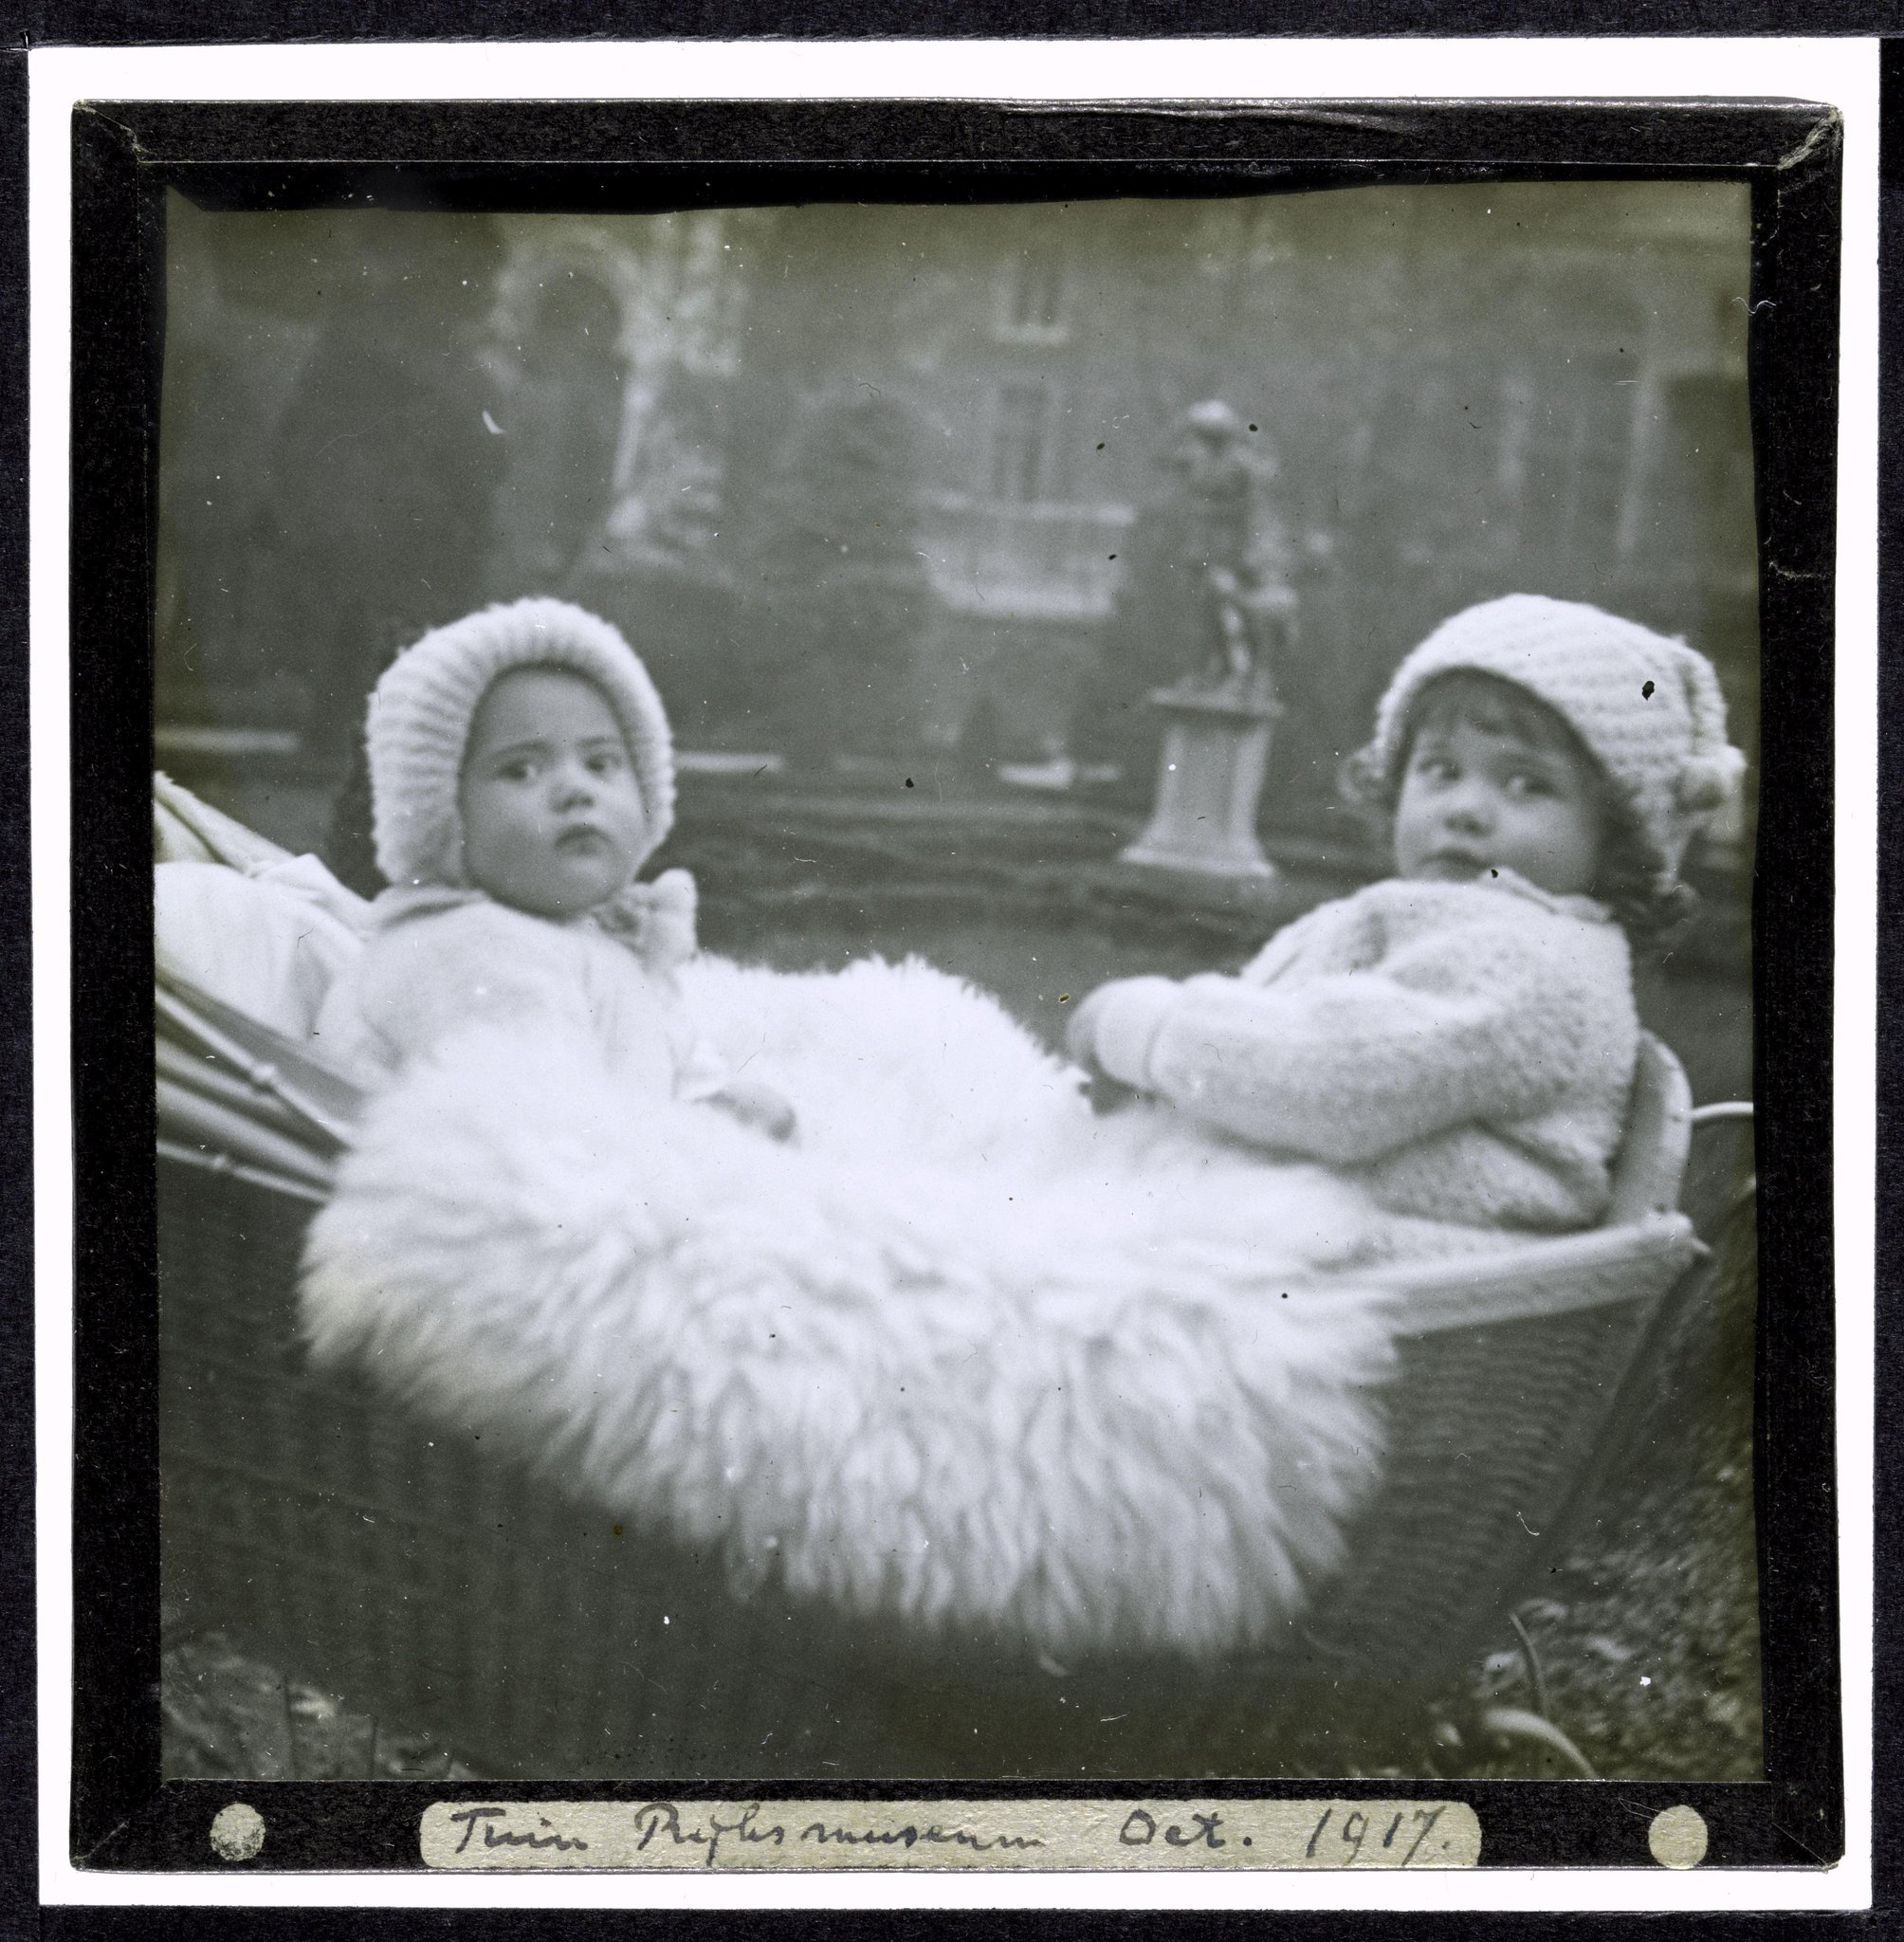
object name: photograph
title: Tuin Rijksmuseum Oct. 1917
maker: Anonymous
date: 1917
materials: glass, ink, paper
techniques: slide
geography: amsterdam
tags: baby-carriage, pram, perambulator, toddler (female), confinement, birth